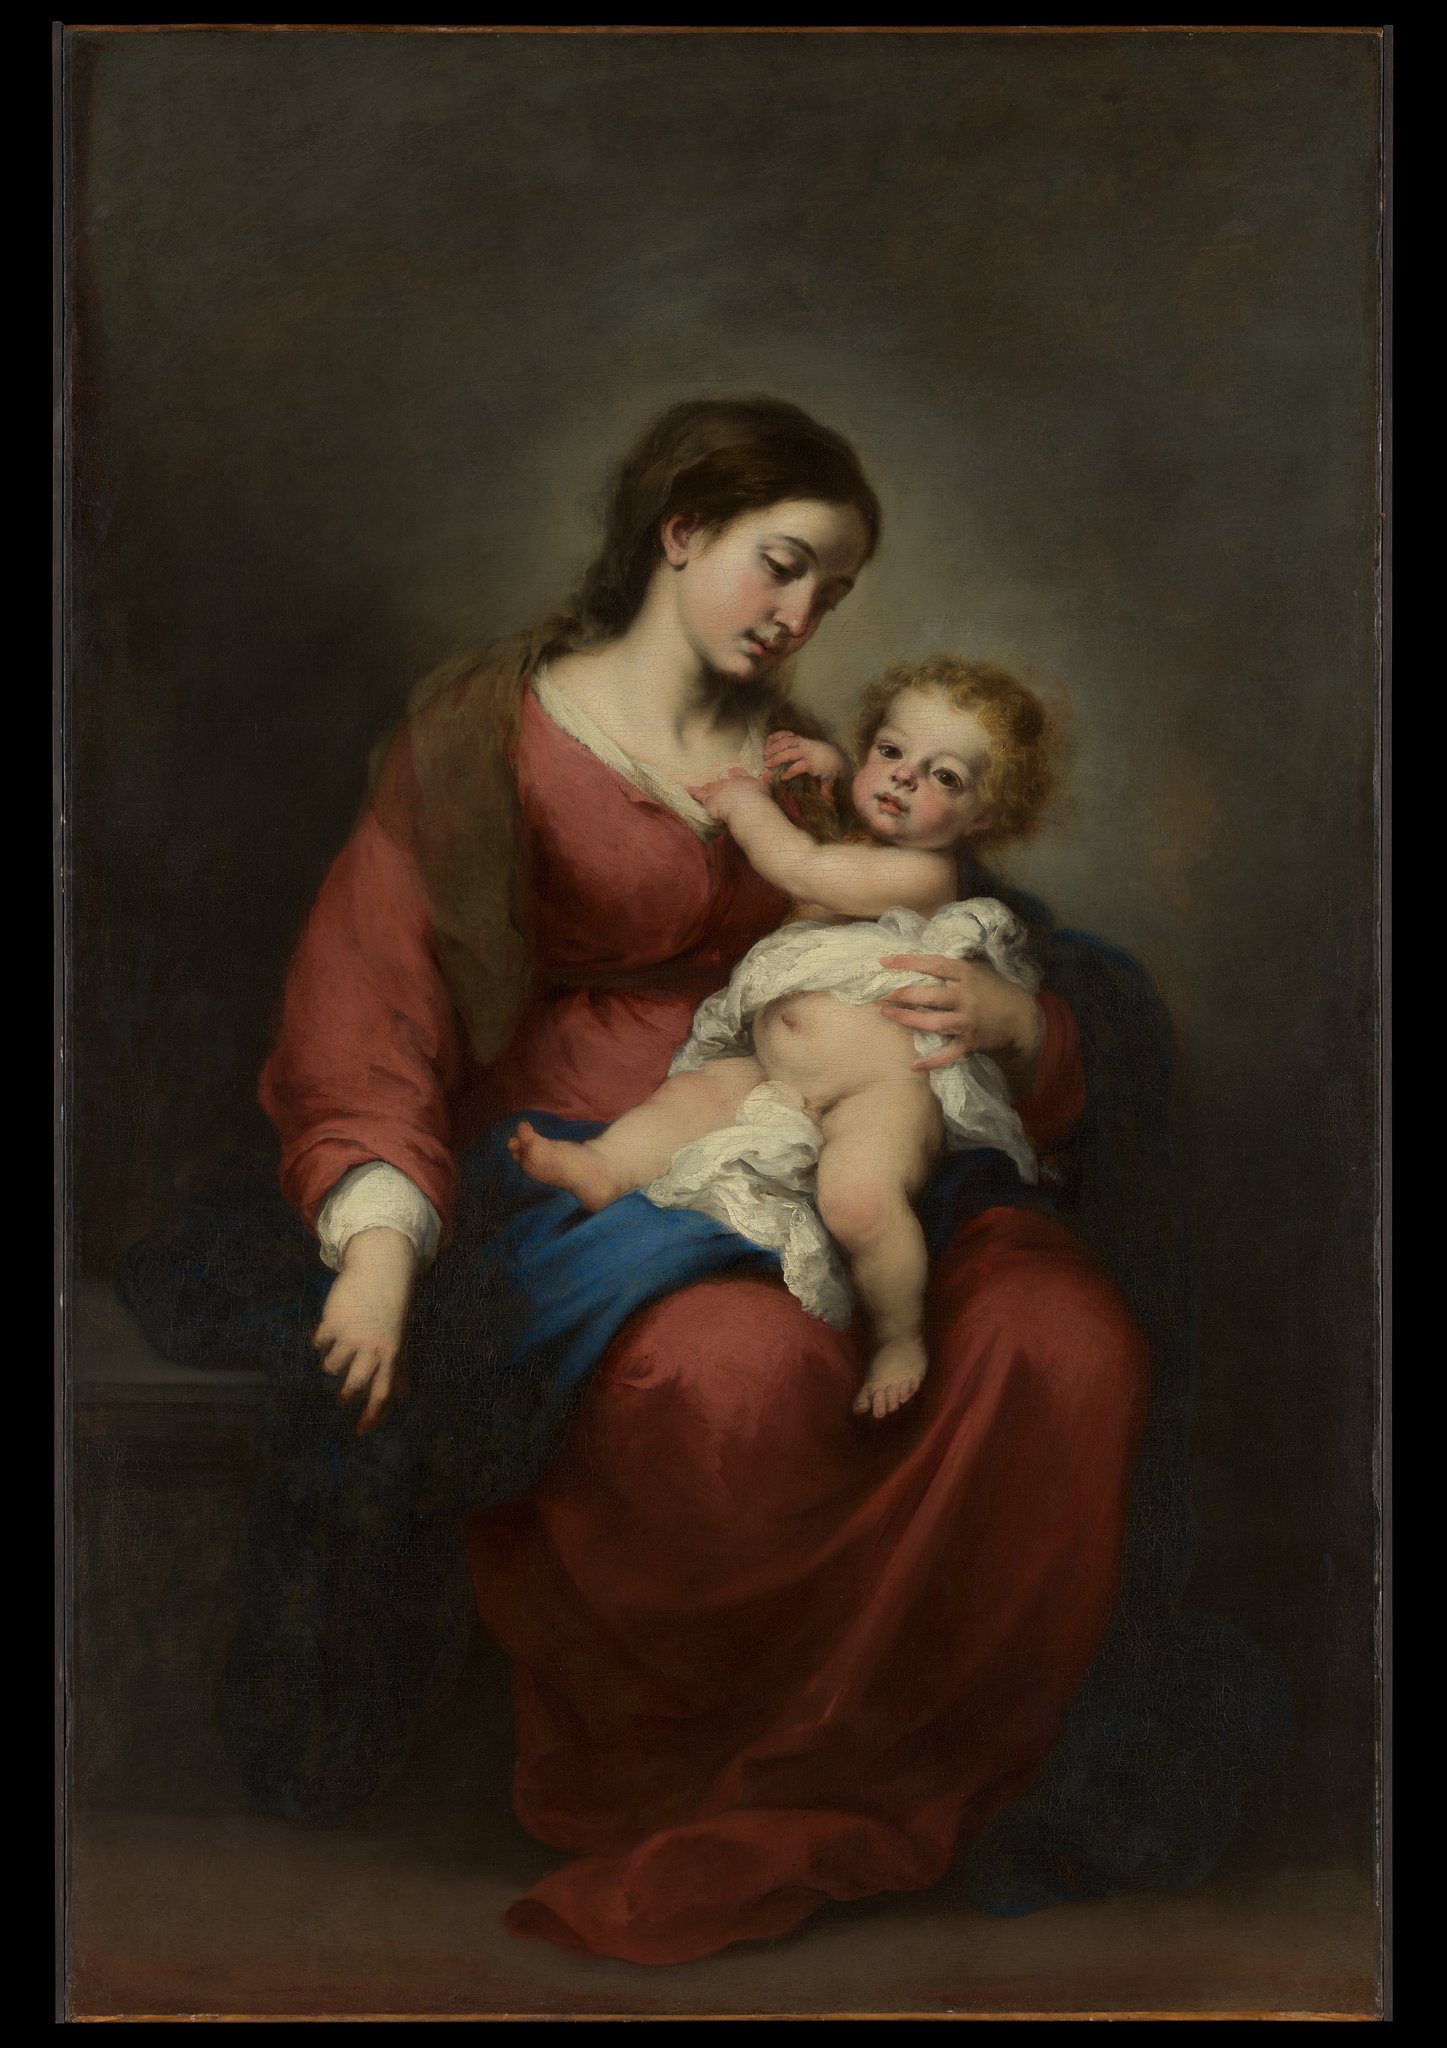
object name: painting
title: Virgin and Child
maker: bartolomé estebán murillo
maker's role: artist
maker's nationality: spanish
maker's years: 1617-1682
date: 1670-1679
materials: canvas, oil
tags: madonna and child